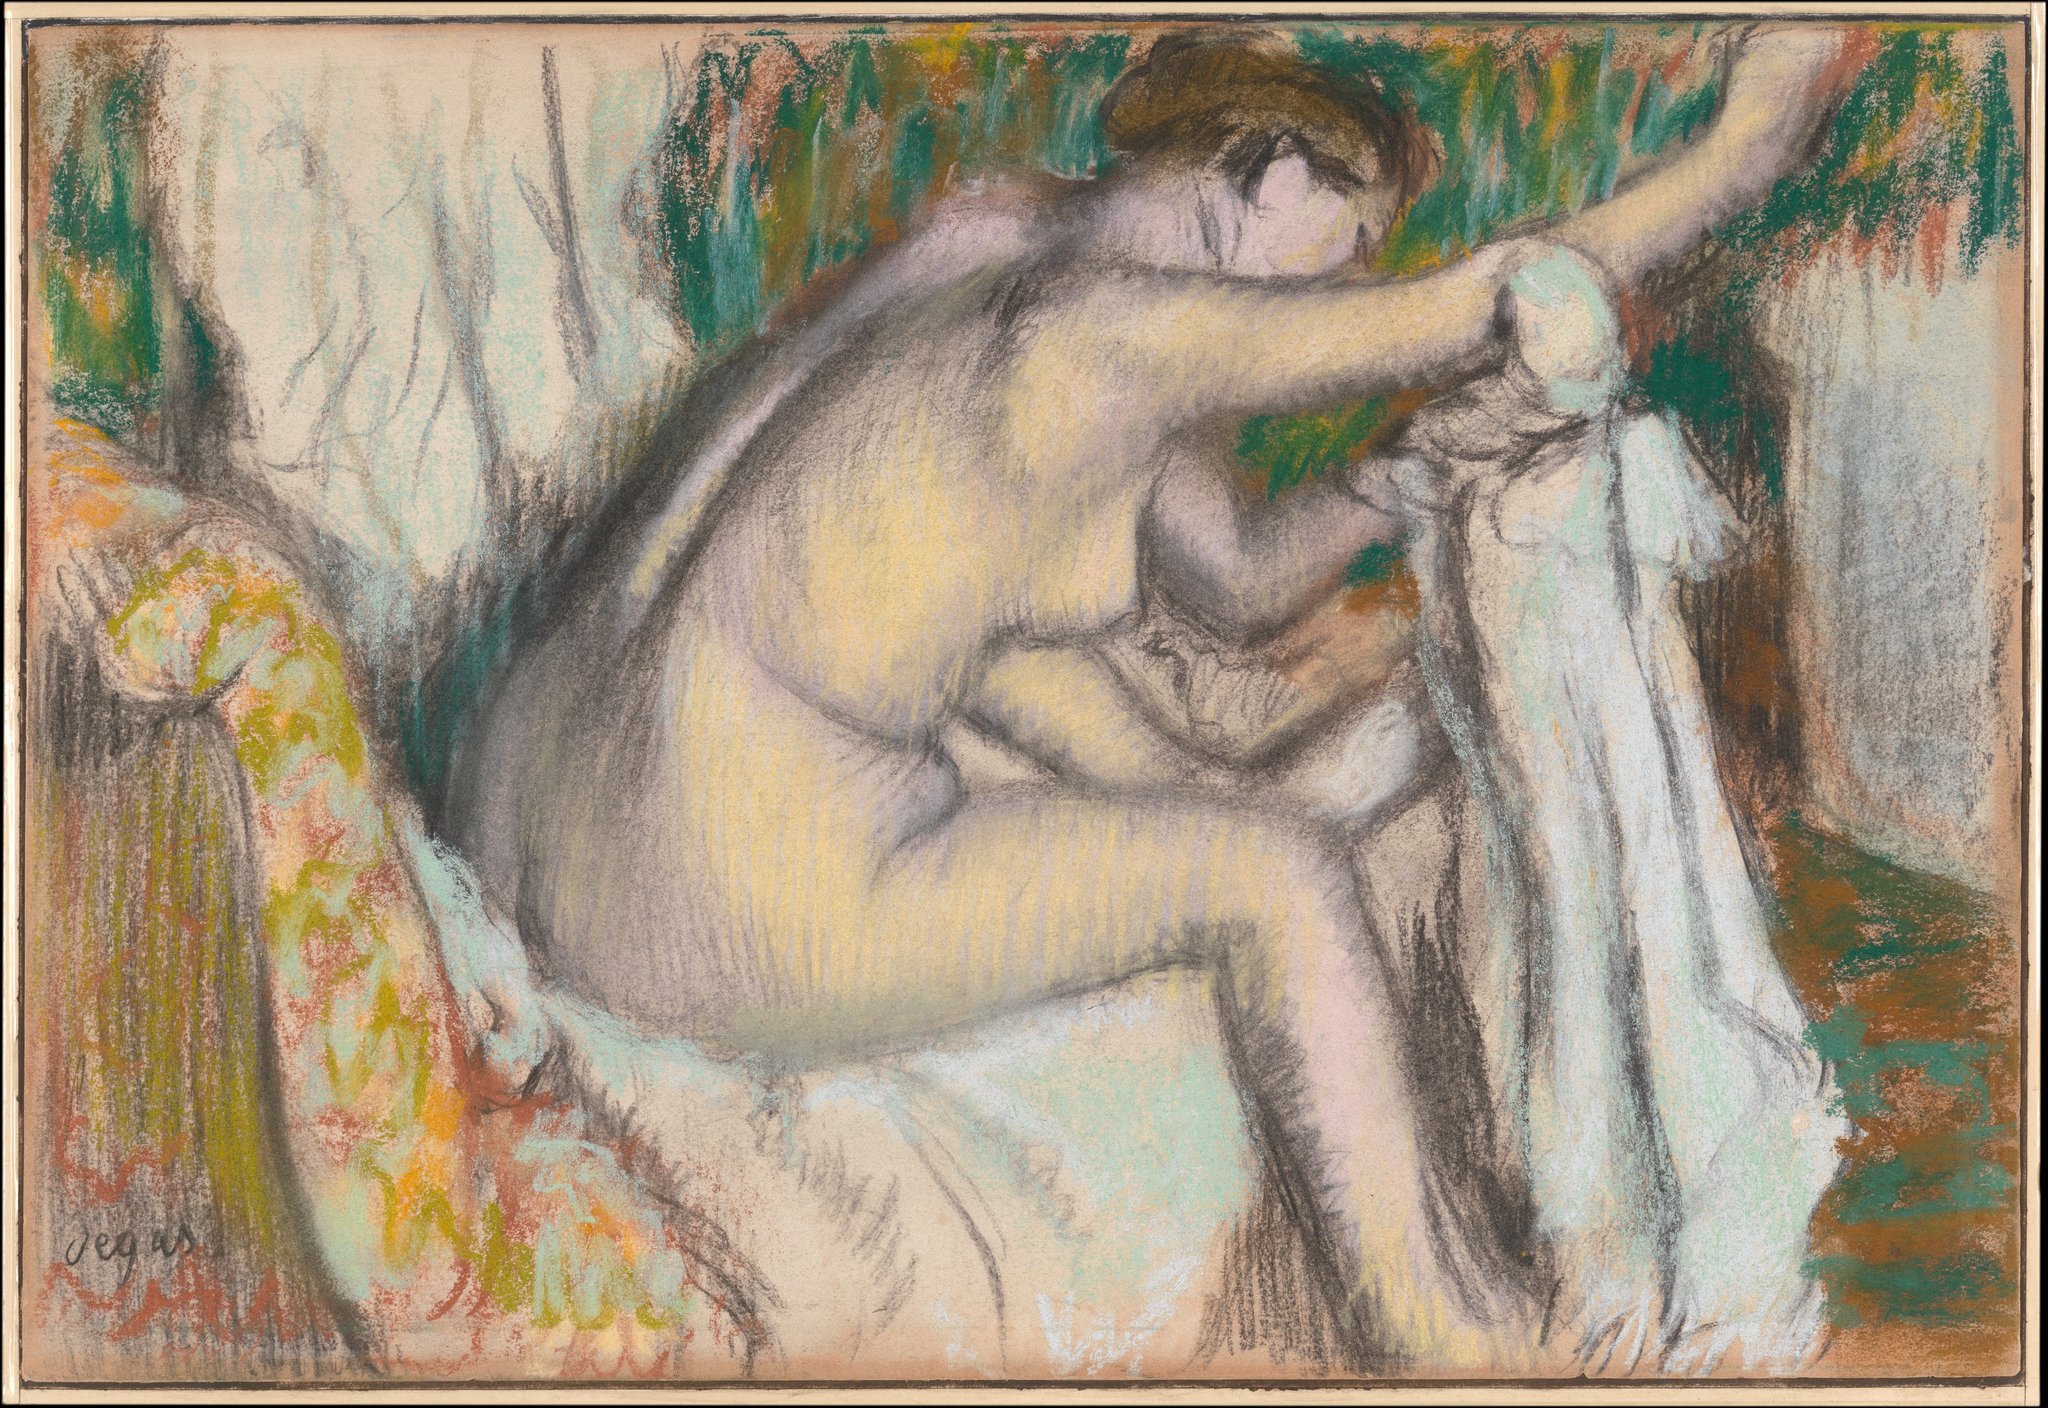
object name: drawing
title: Woman Drying Her Arm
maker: edgar degas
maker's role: artist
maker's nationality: french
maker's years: 1834-1917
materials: charcoal, pastel, paper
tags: female nudes